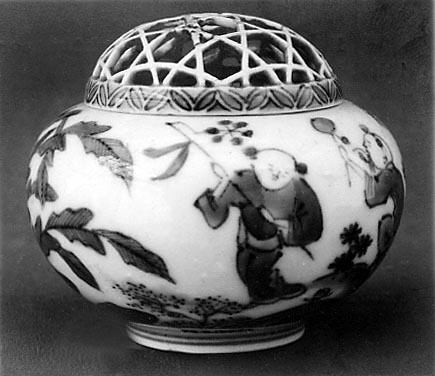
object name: incense burner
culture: japanese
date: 1701-1800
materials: glaze, porcelain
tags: men